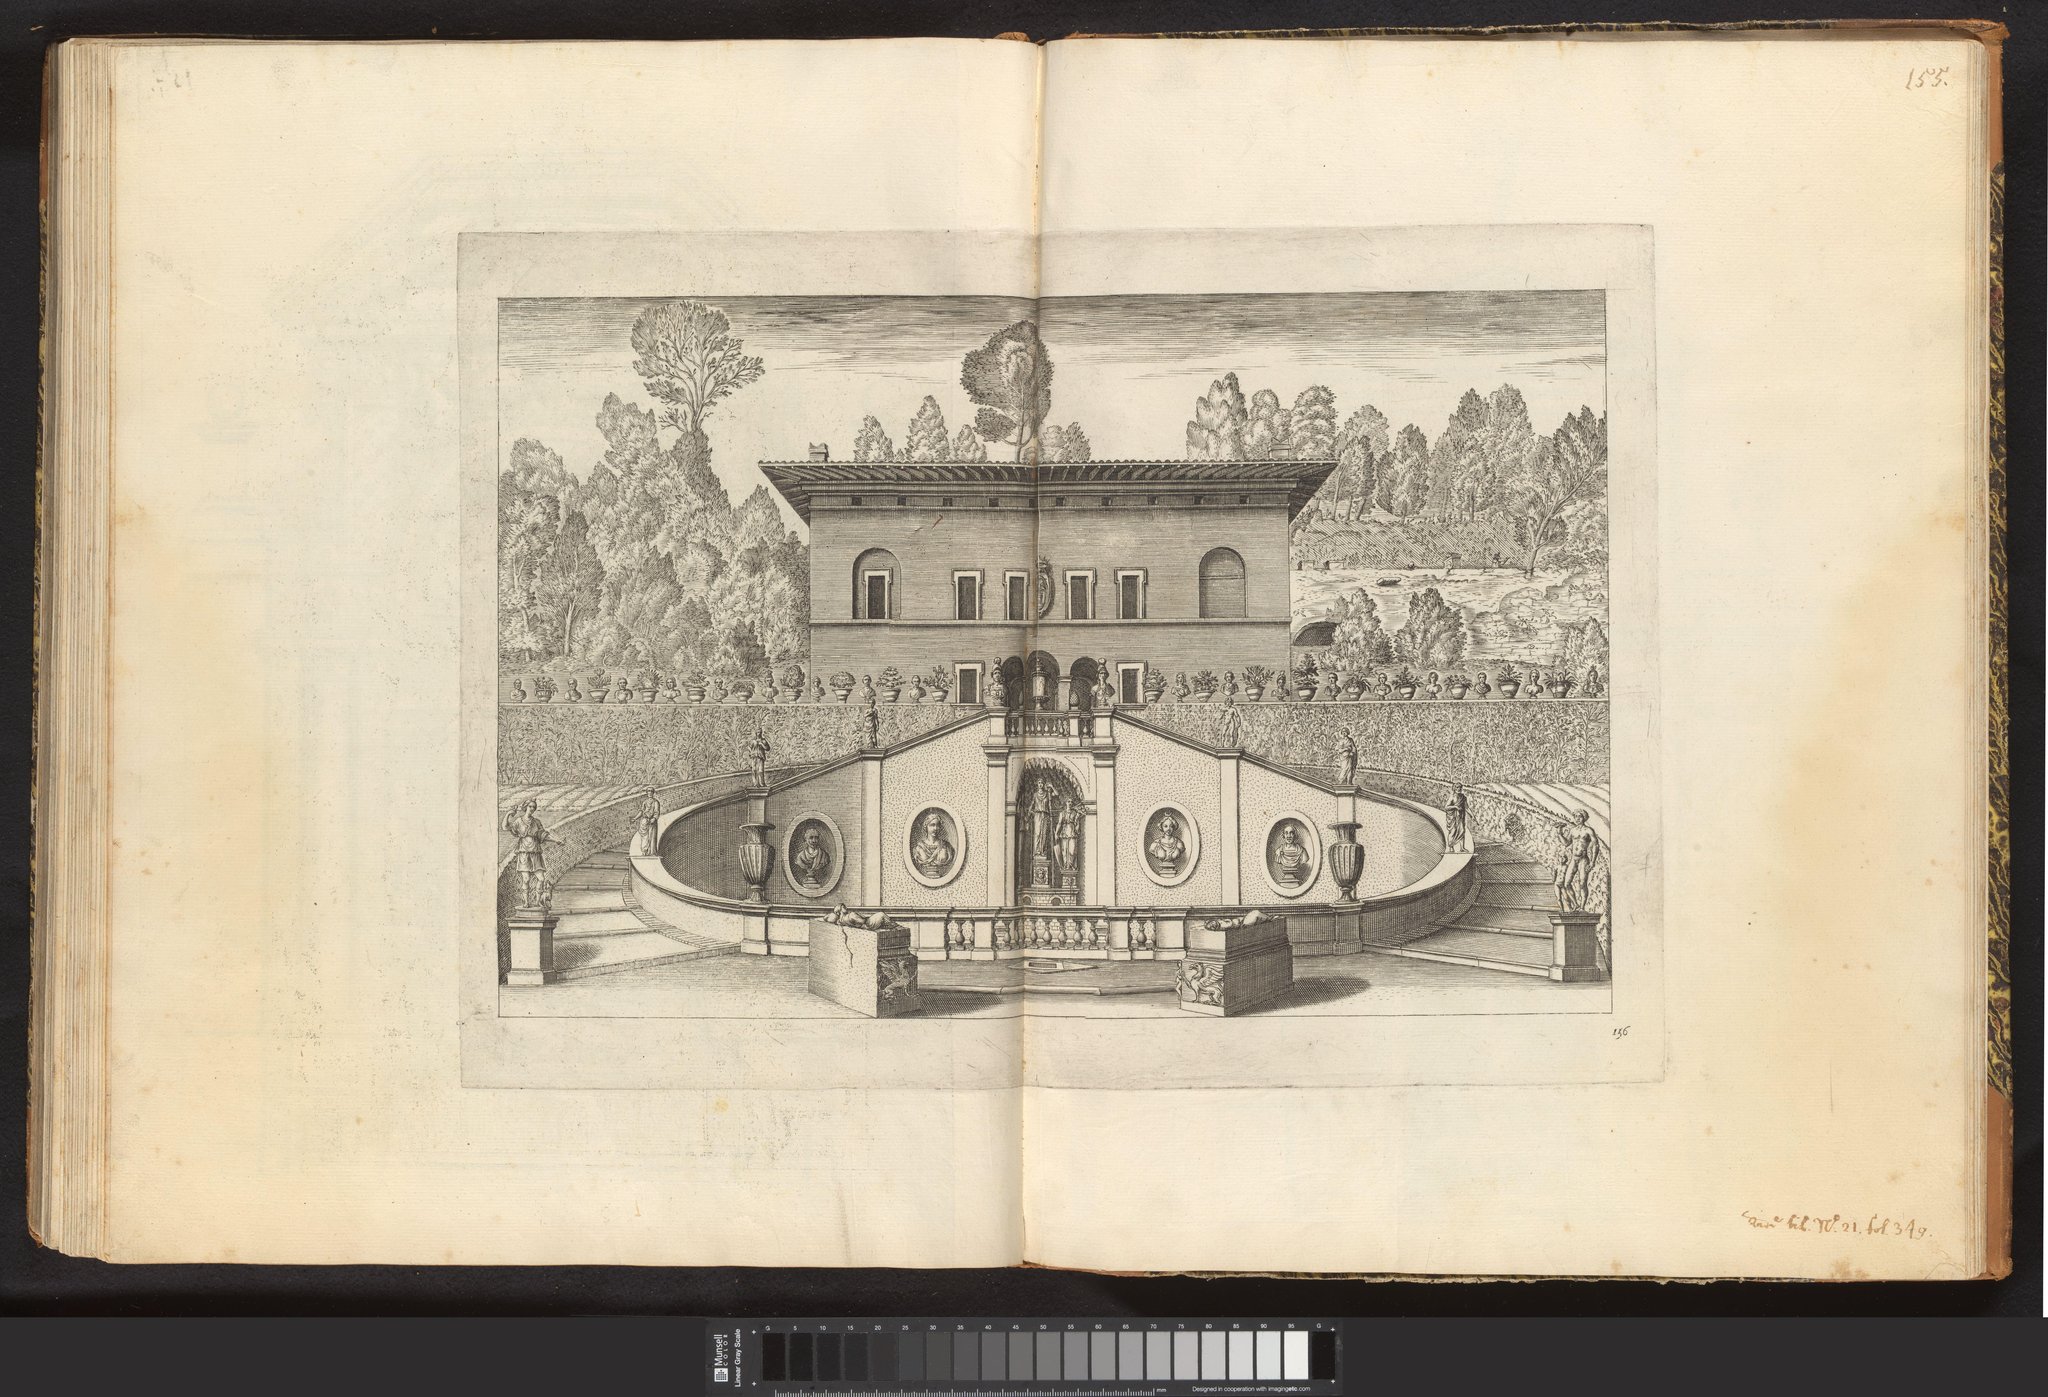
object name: print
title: Galleria Giustiniana del Marchese Vincenzo Giustiniani II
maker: valérien regnard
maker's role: print maker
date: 1636-1647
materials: paper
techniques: engraving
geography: rome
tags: civic architecture; edifices; dwellings, rome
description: Muur met een beelden in nissen en een beeld van Jupiter onder een boog in de wijngaard van Sint-Jan van Lateranen. Boven de poort het wapenschild van de familie Giustiniani. Prent maakt deel uit van een album met een serie prenten naar de sculpturen in de verzameling in de Galleria Giustiniani te Rome.